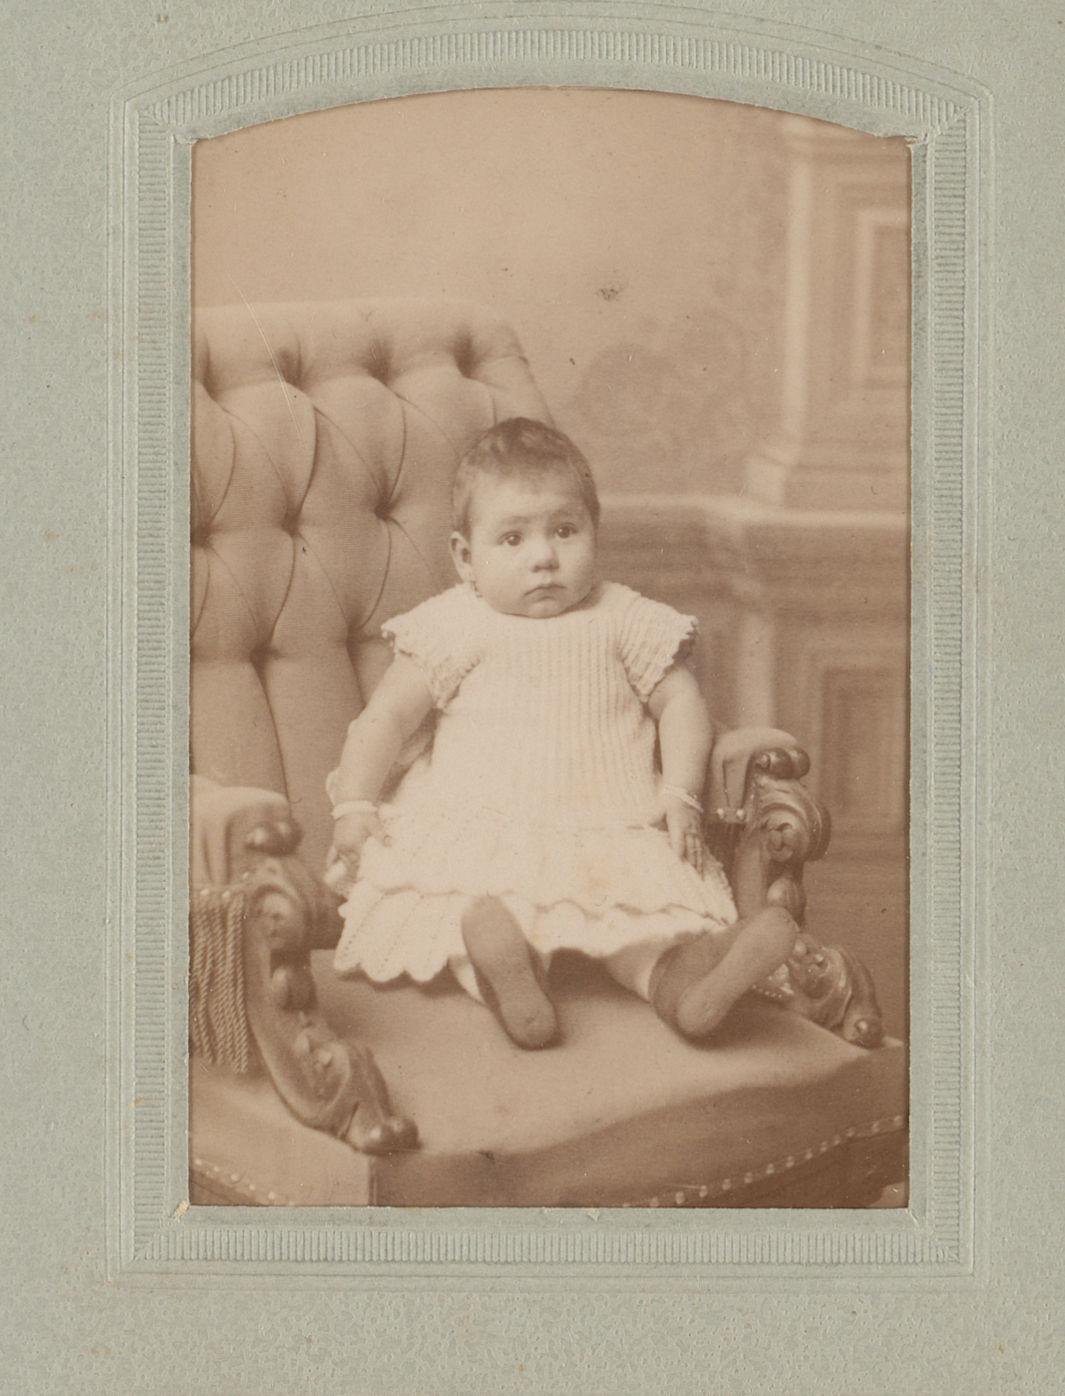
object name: album leaf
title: Portret van een baby op een stoel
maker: albert greiner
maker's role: fotograaf, fotostudio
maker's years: 1833-1890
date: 1890-1910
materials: cardboard, photographic support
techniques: albumen print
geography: amsterdam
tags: historical persons, infant, baby ~ the ages of man